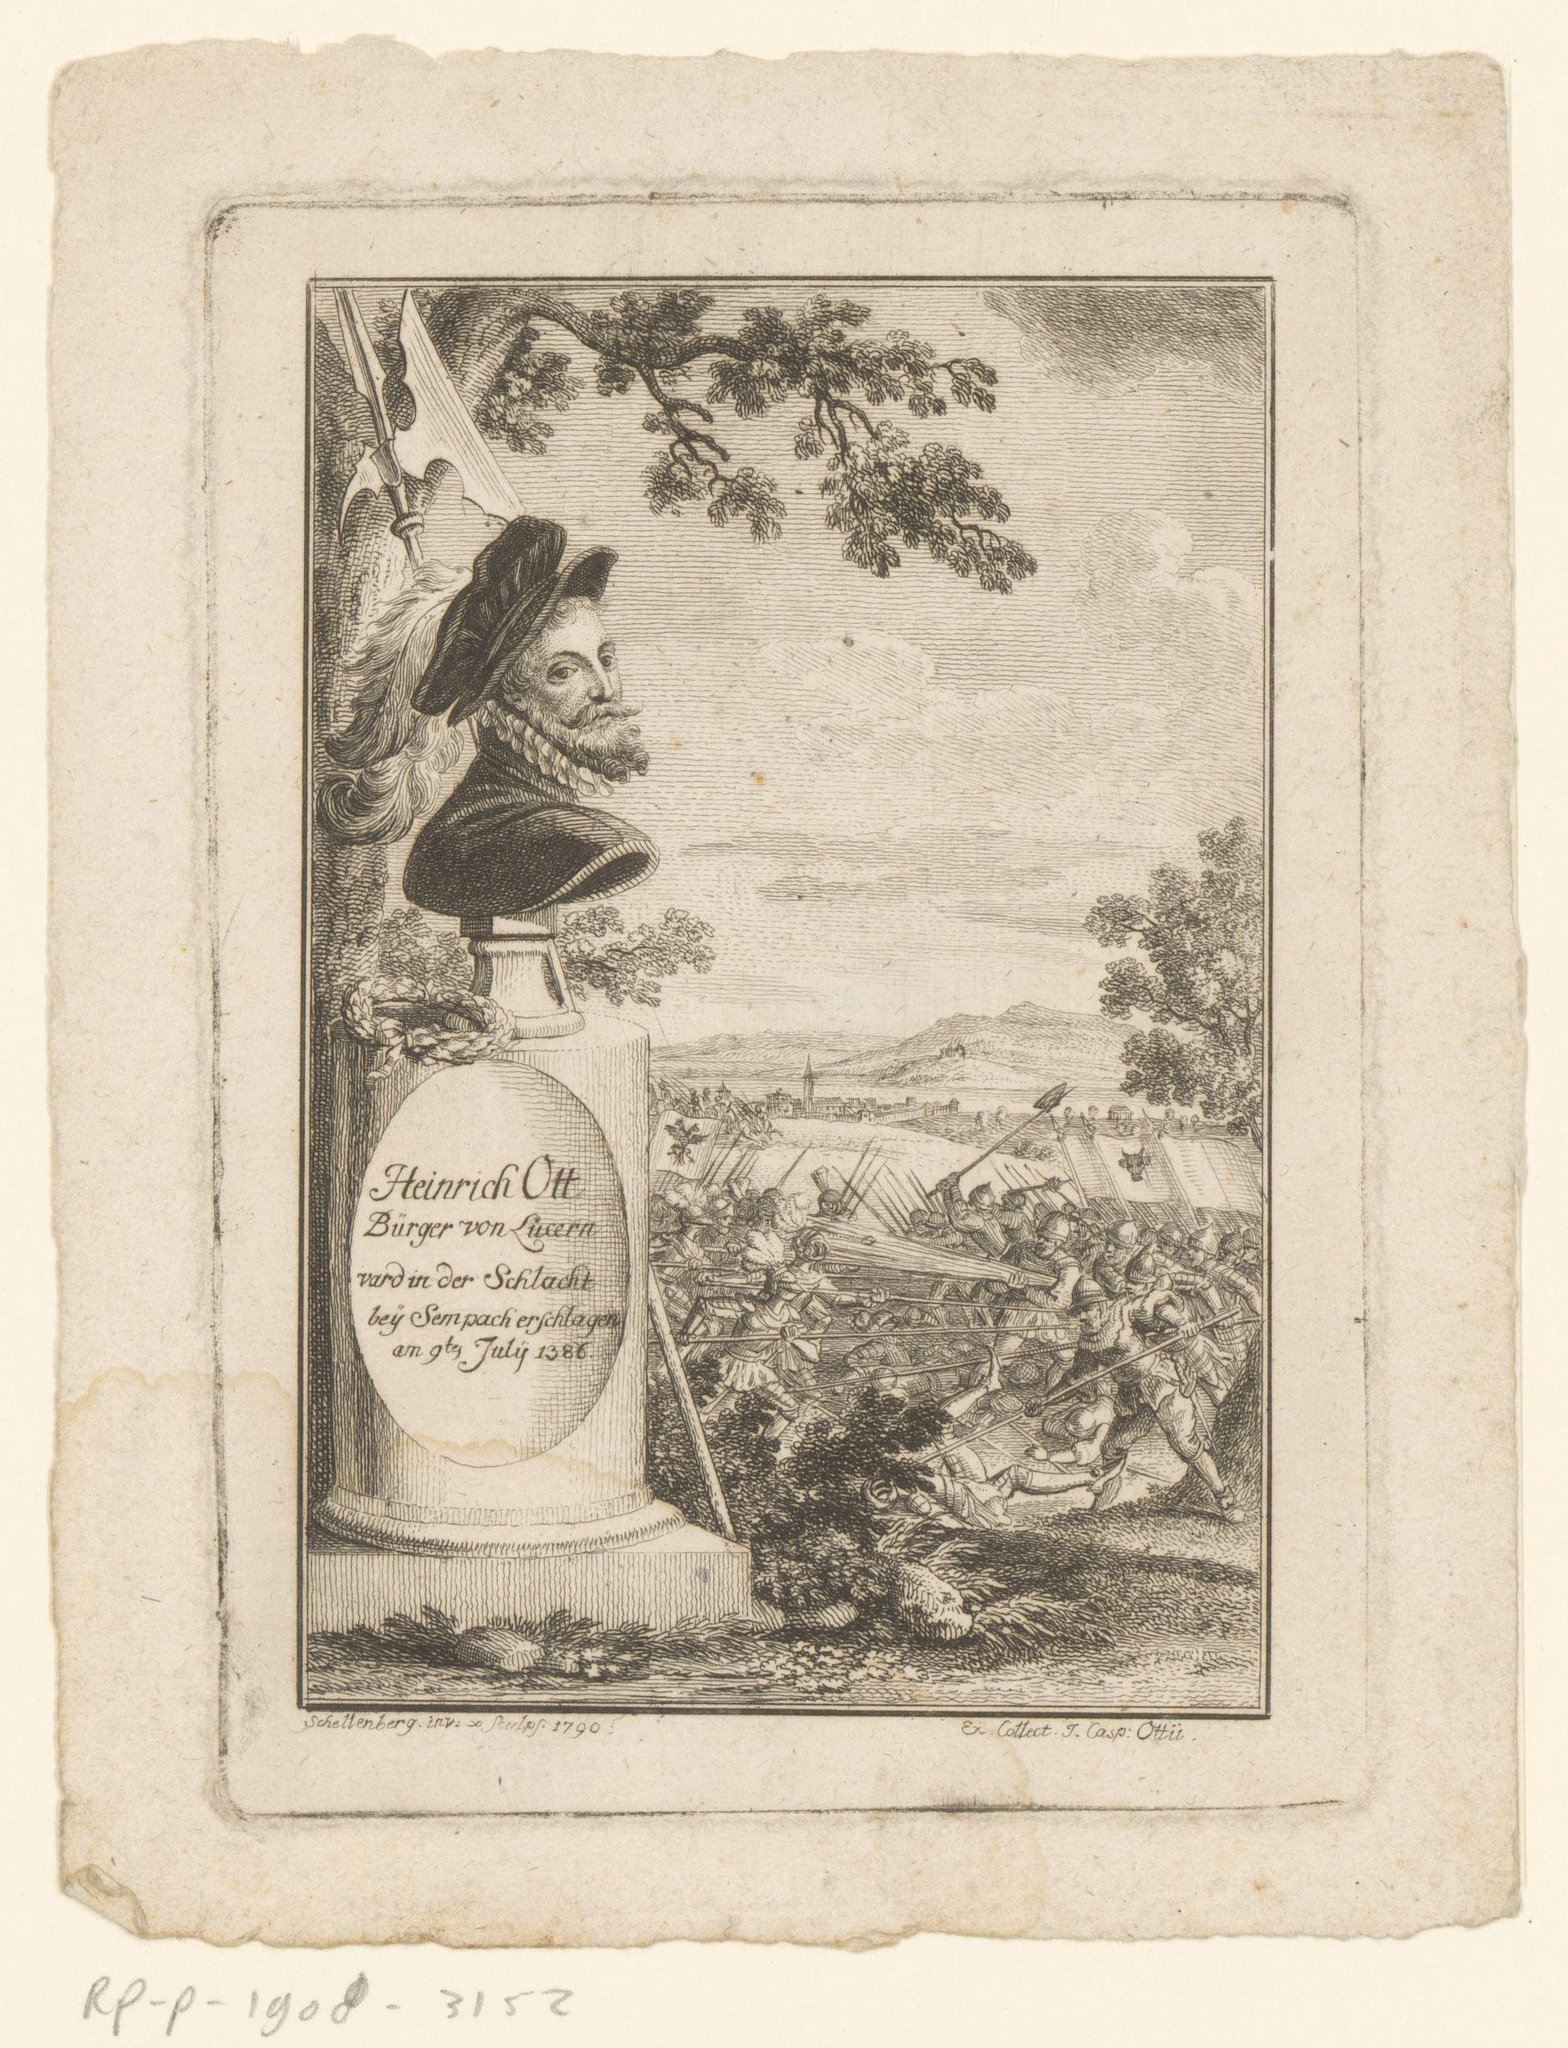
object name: print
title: Portret van Heinrich Ott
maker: johann rudolph schellenberg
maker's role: print maker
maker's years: 1740-1806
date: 1790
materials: paper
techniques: etching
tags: historical persons, battle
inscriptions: collector's mark: Lugt 2228